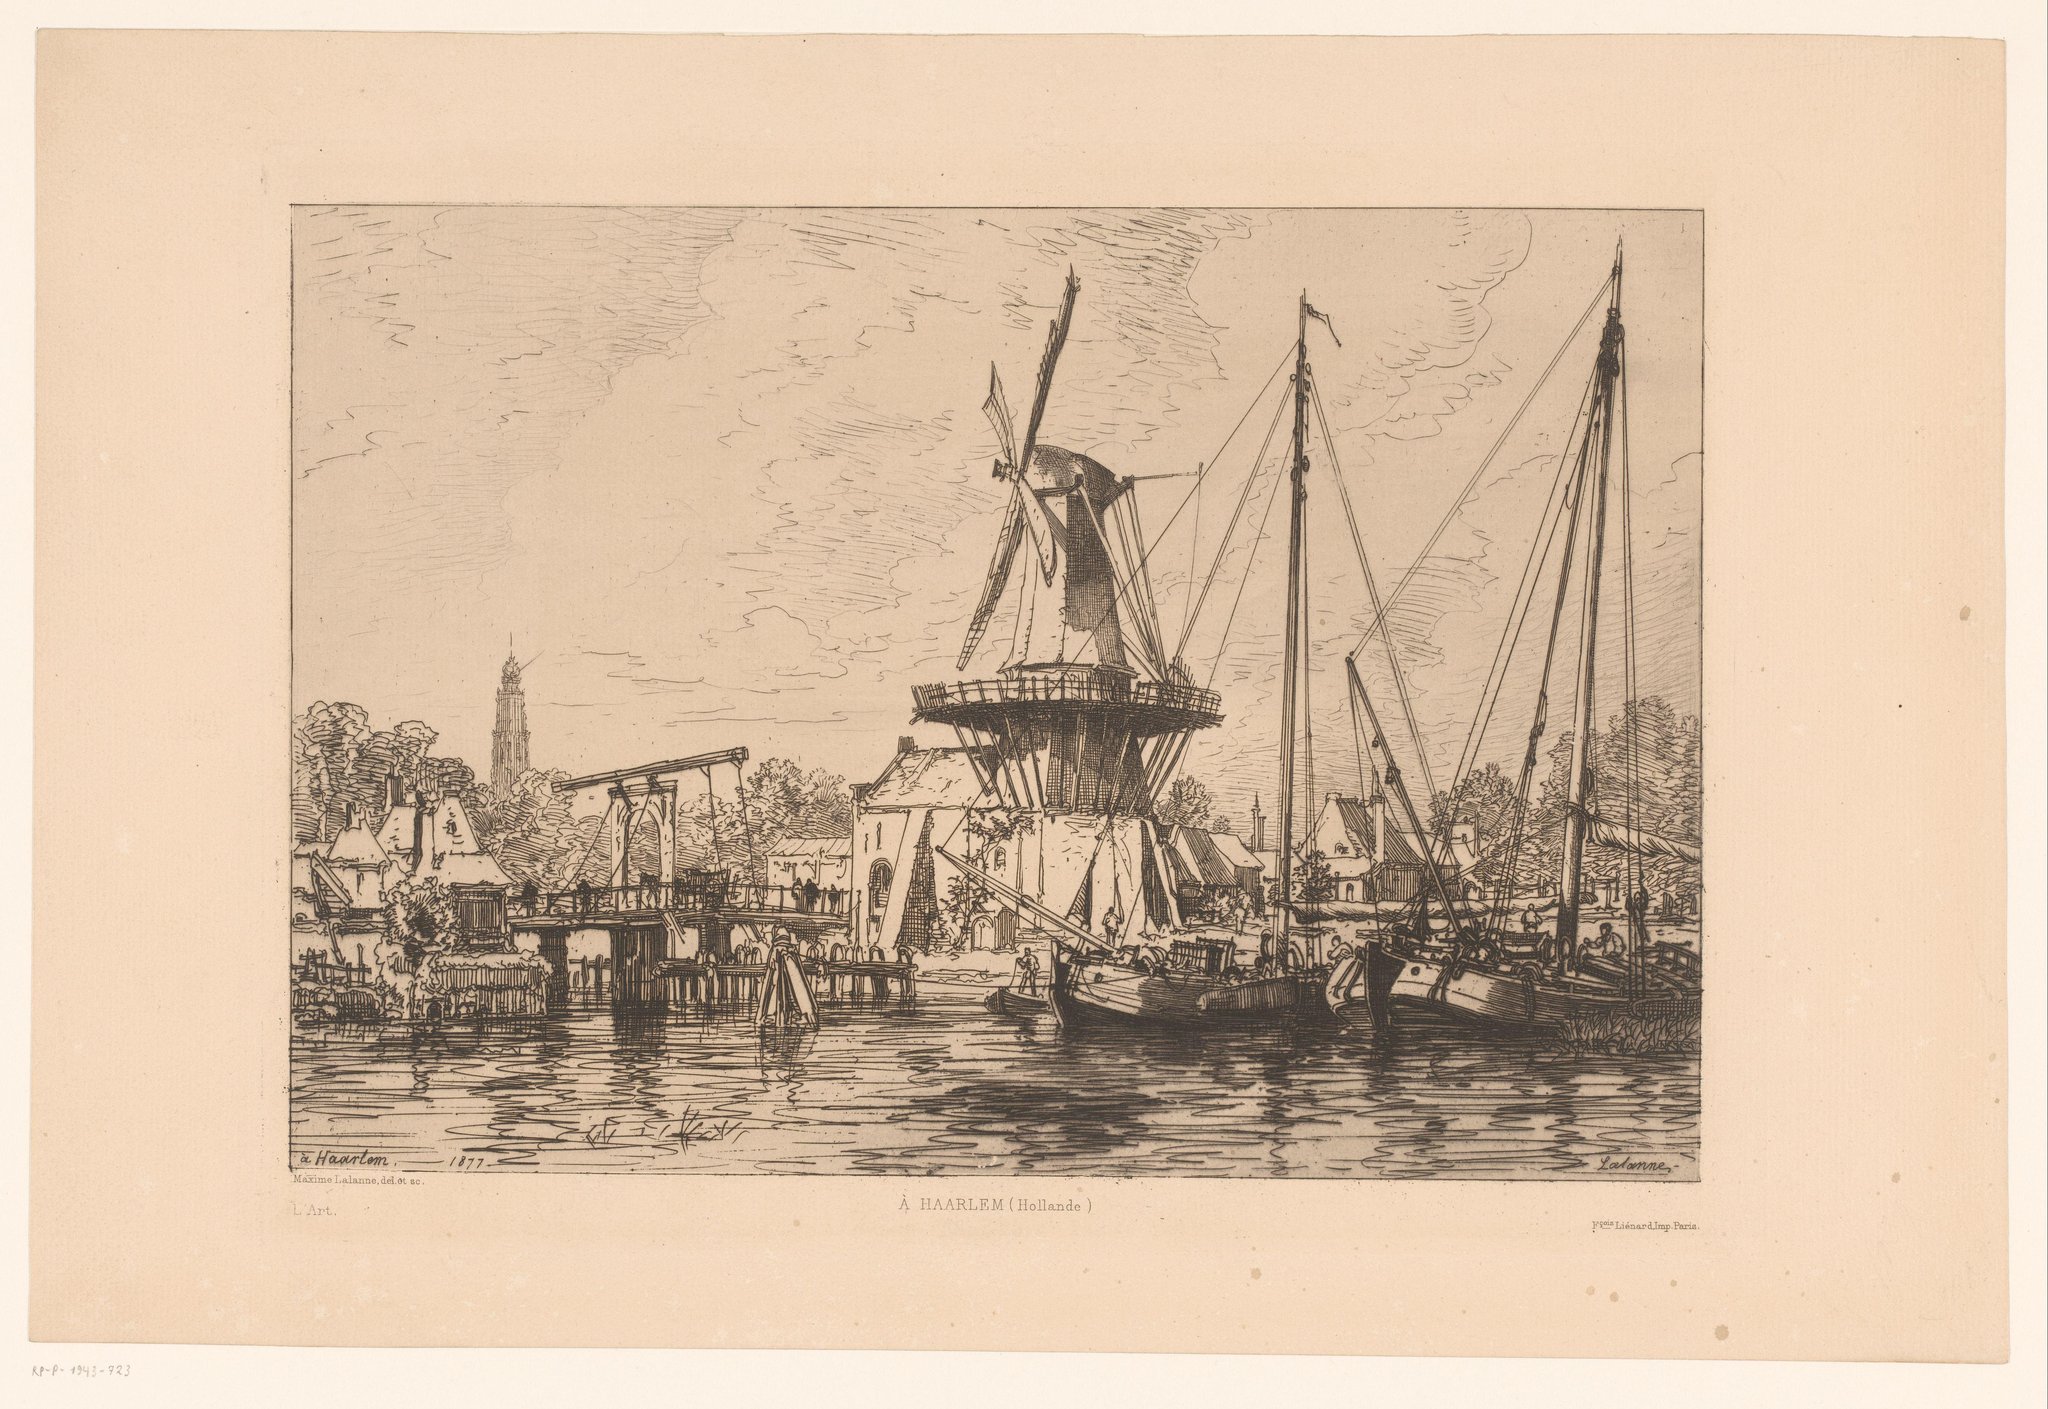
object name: print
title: À Haarlem (Hollande)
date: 1877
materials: paper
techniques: drypoint, engraving, etching, intaglio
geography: paris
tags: city-view, and landscape with man-made constructions, water course, haarlem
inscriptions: collector's mark: Lugt 2228